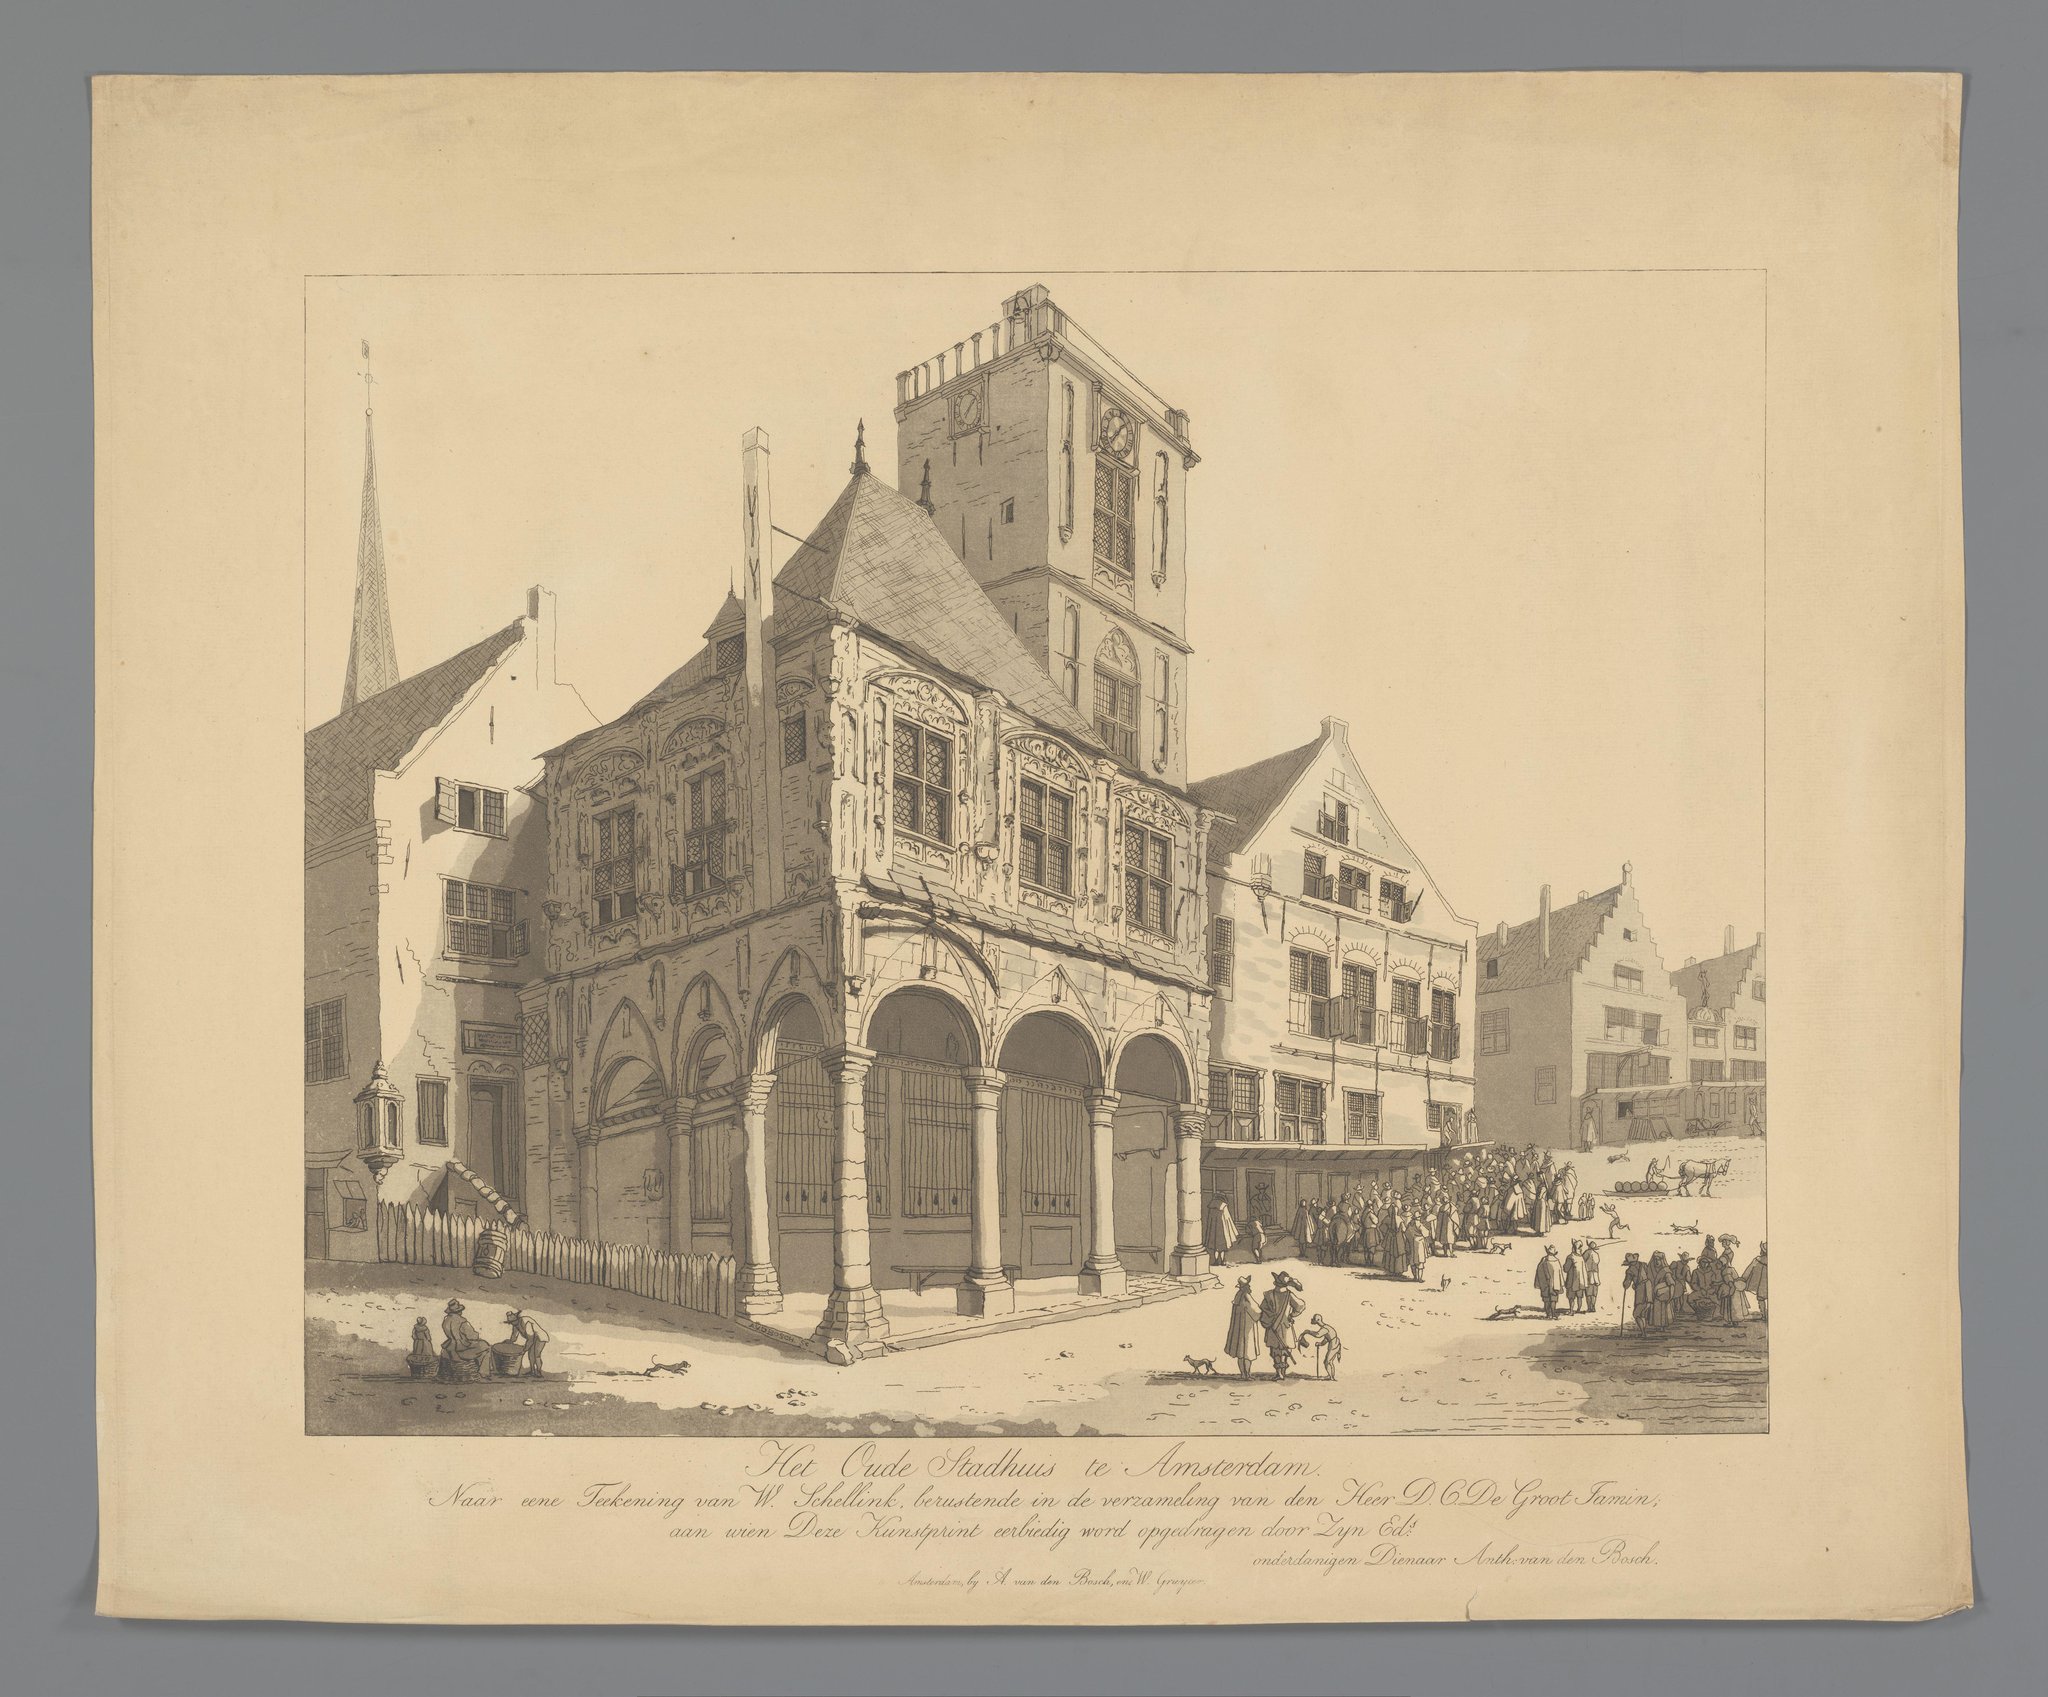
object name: print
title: Het Oude Stadhuis te Amsterdam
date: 1778-1838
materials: paper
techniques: aquatint, etching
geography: amsterdam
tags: city-view, and landscape with man-made constructions, civic architecture; edifices; dwellings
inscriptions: collector's mark: Lugt 2233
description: Het Oude Stadhuis van Amsterdam, voor de verwoesting door de grote brand van 1652. Een groep mensen staat te wachten voor een zijgebouw. Op de voorgrond worden twee mannen aangesproken door een bedelaar.